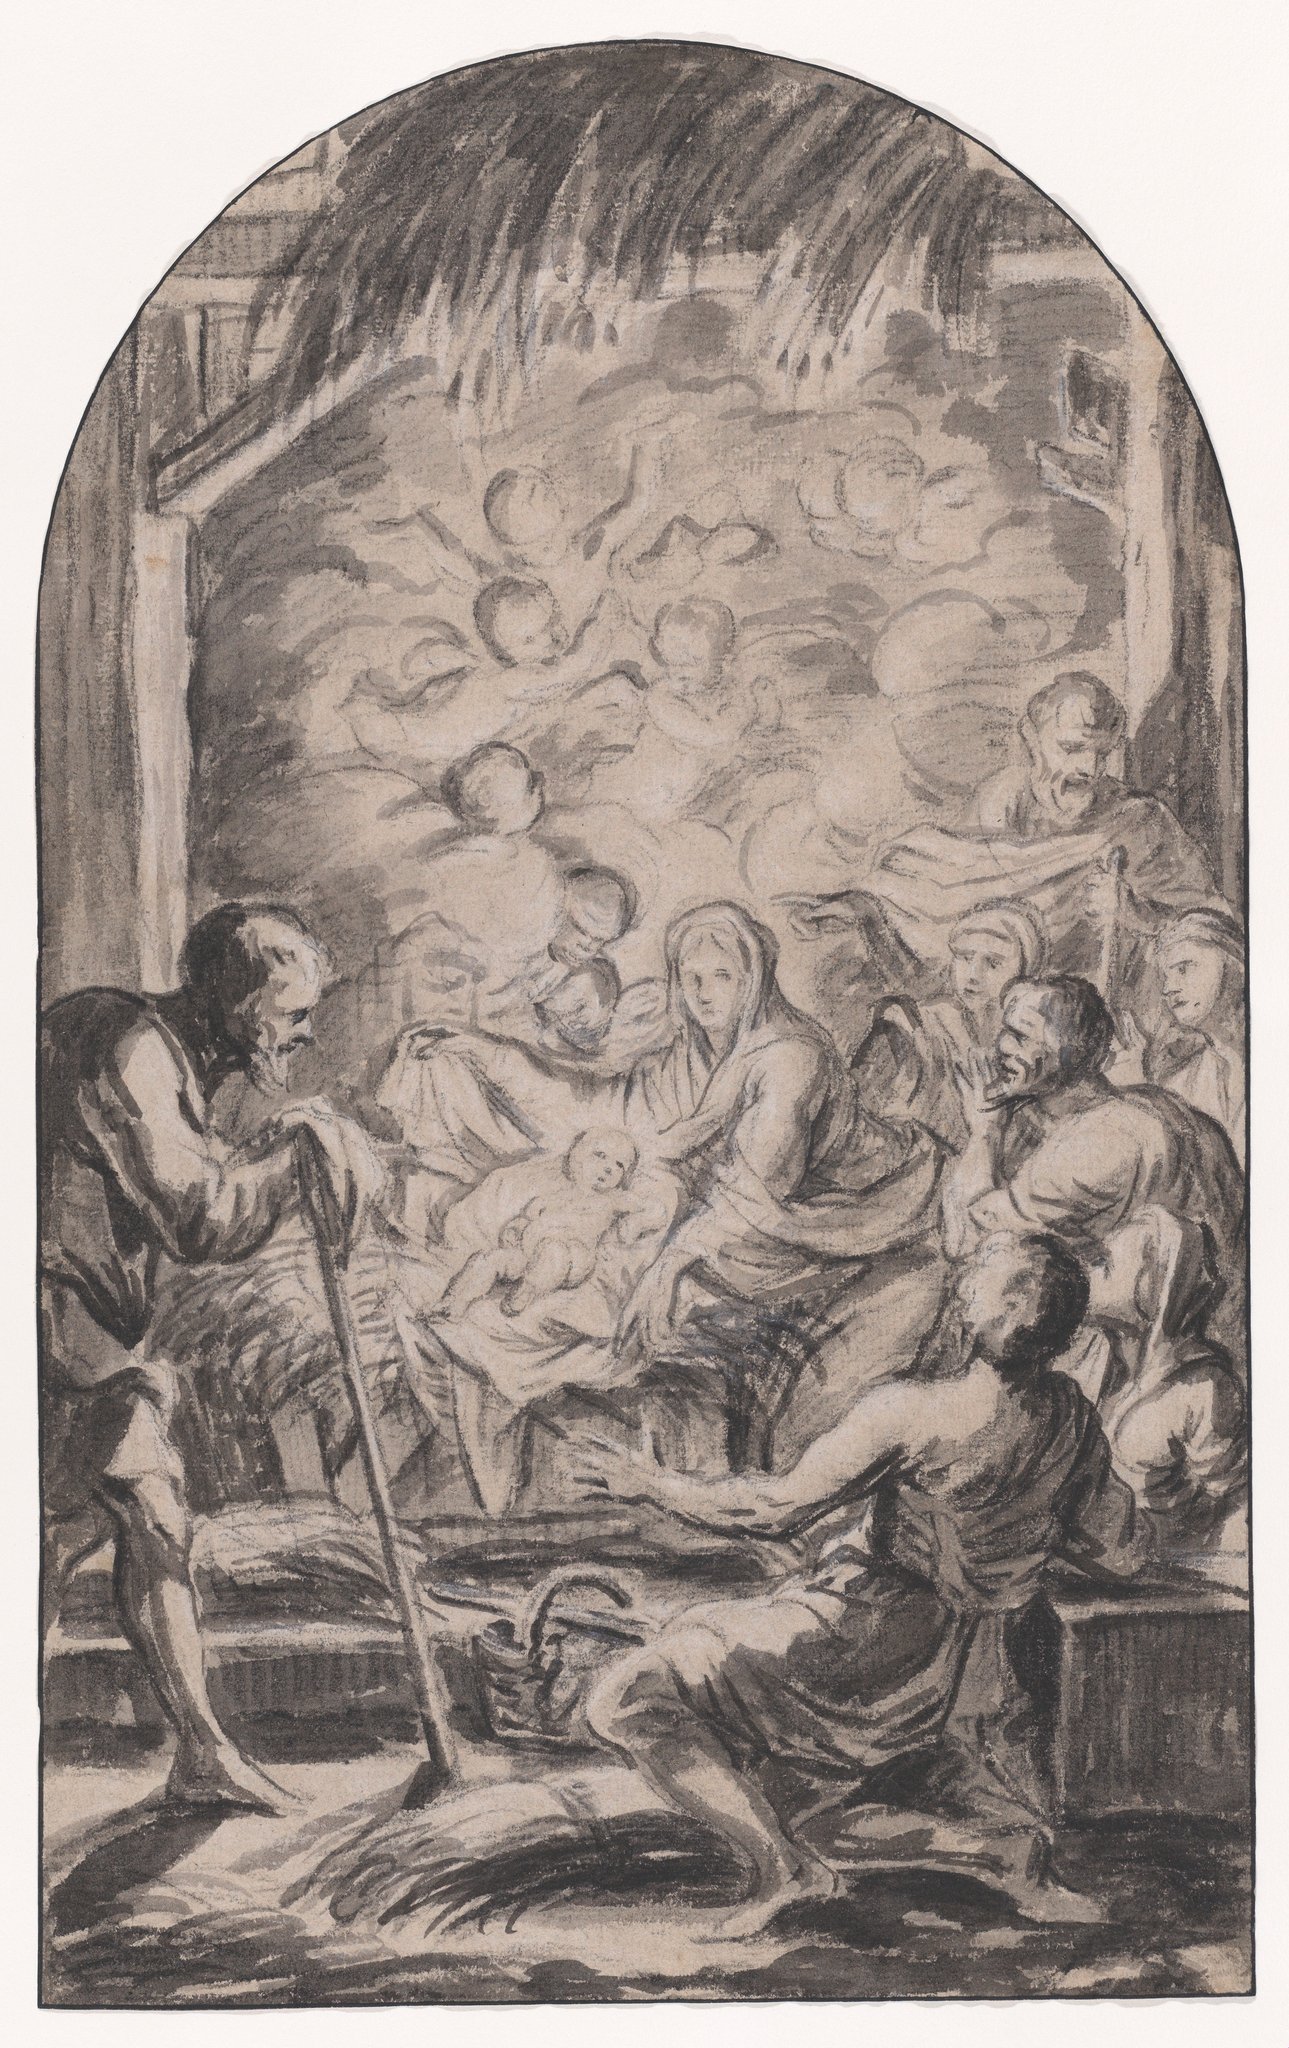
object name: drawing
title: Adoration of the Shepherds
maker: jan boeckhorst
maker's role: artist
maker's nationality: flemish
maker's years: 1599-1668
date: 1634-1666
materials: chalk, ink, paper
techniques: drawing, highlighting, wash